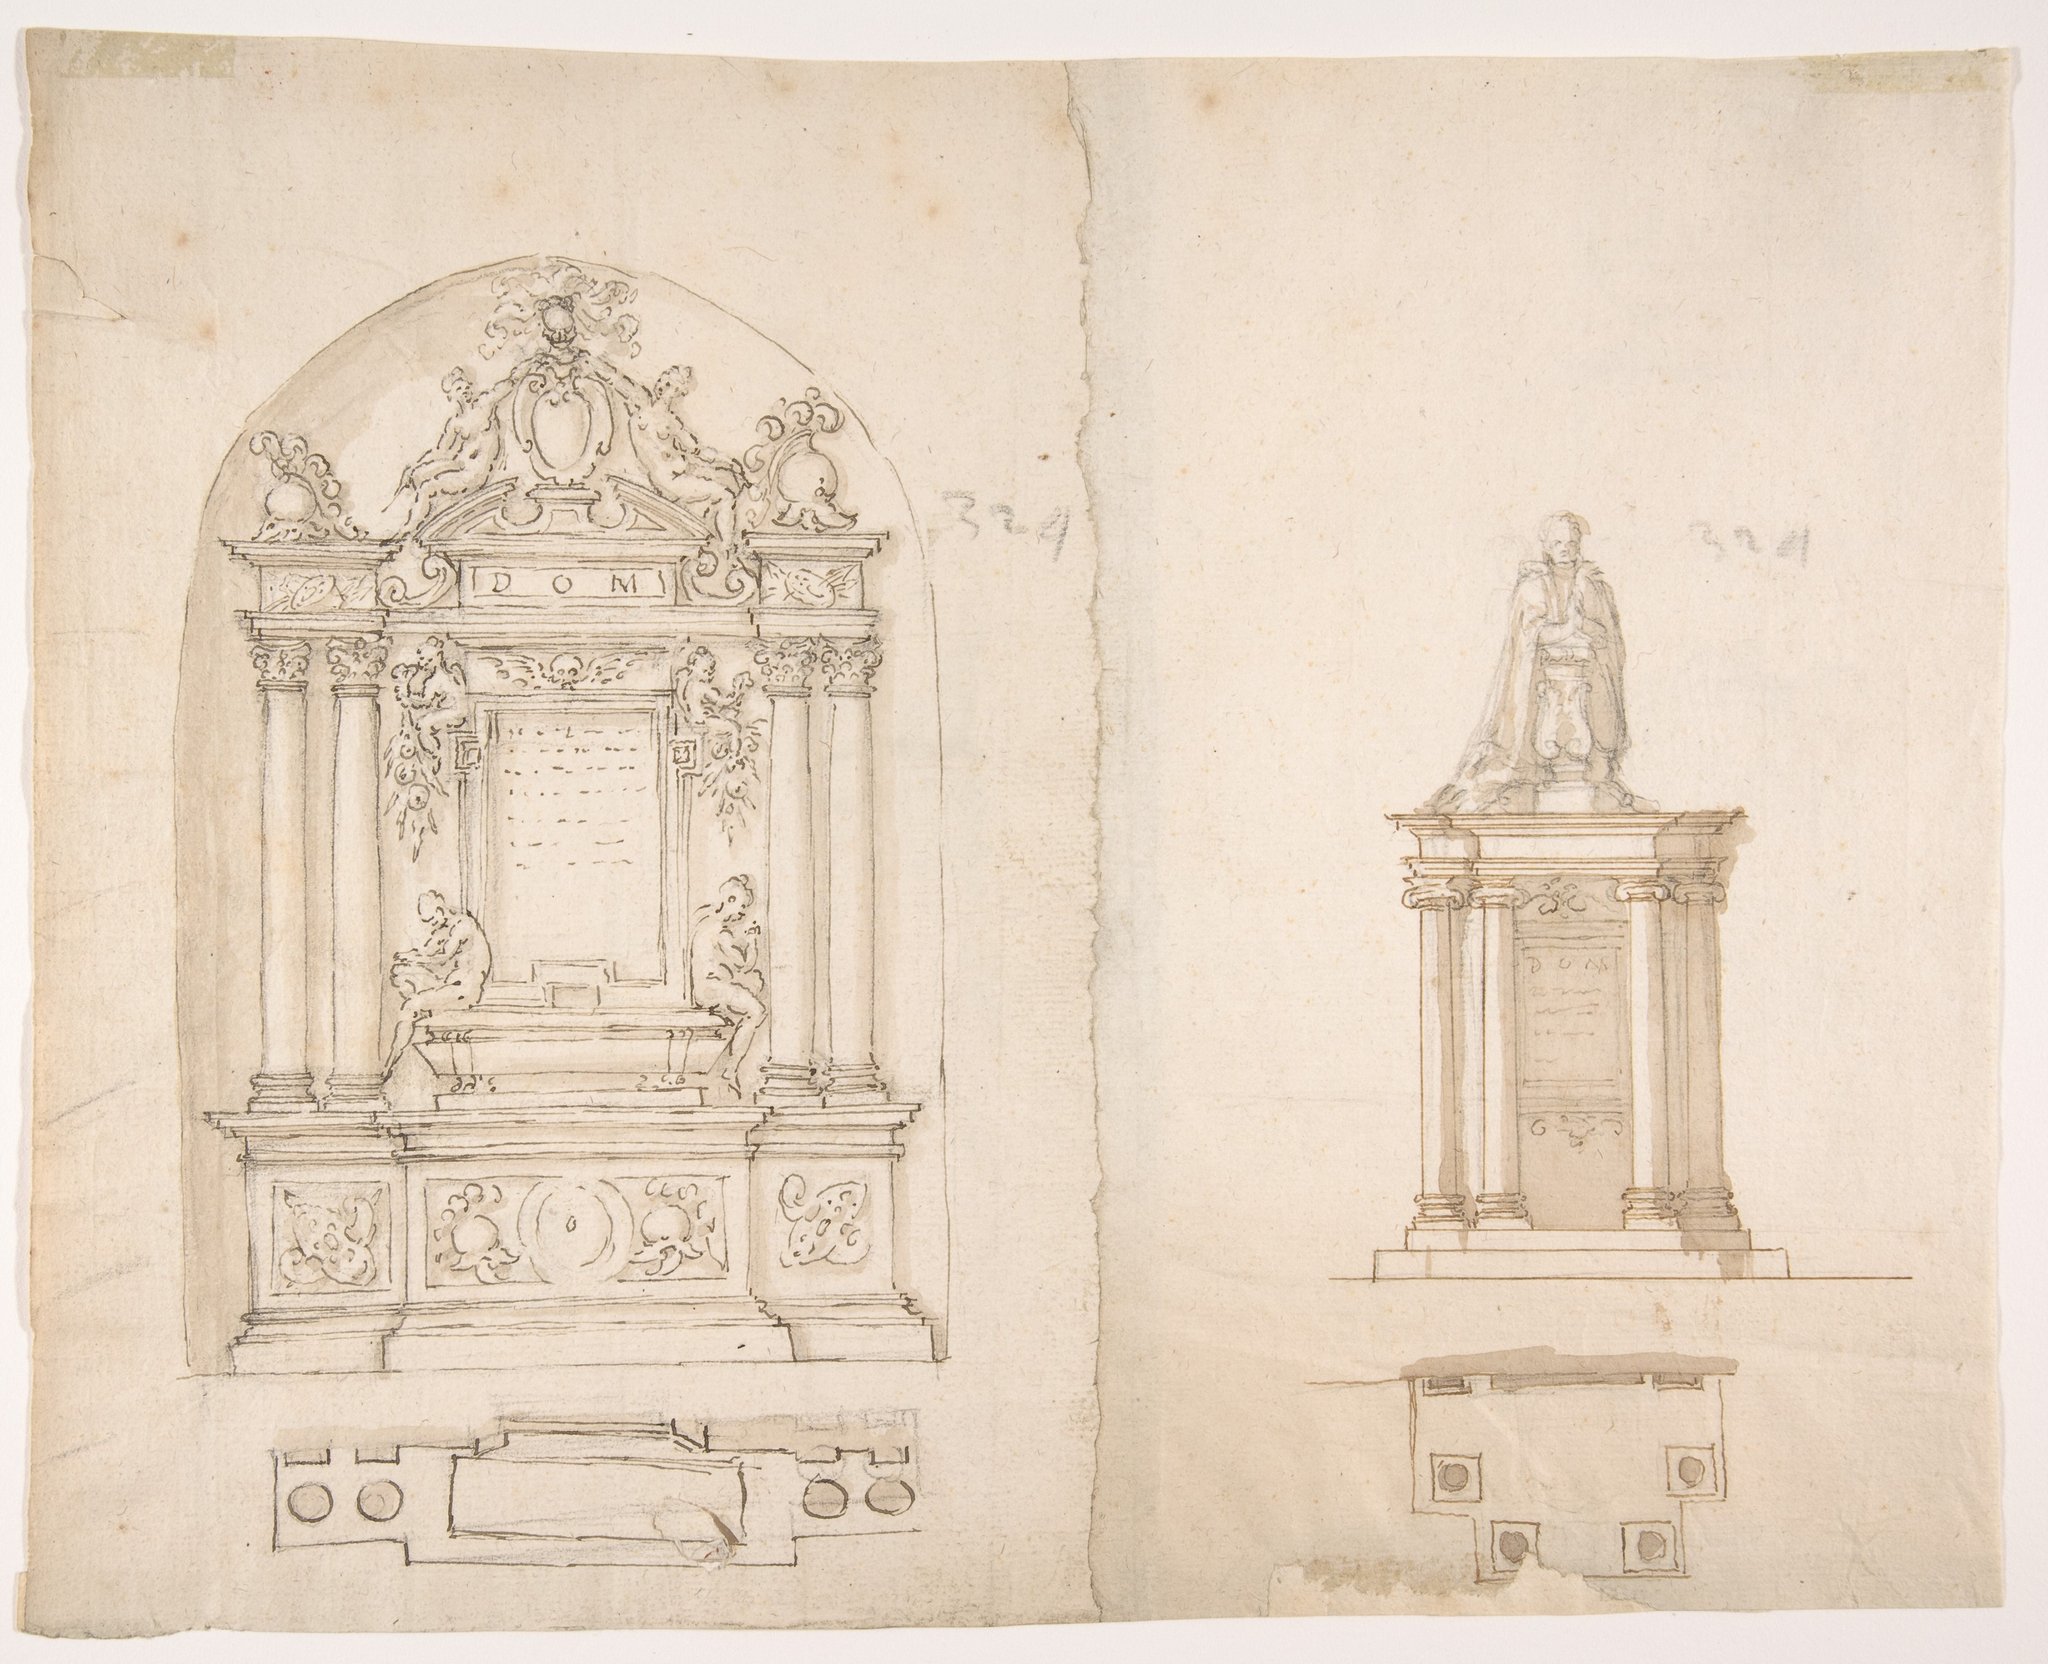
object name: drawing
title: Two Designs for Tombs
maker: anonymous, french, 16th century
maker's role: artist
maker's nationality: french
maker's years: 1500-1600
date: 1501-1600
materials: chalk, ink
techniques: brush, pen, wash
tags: tombs